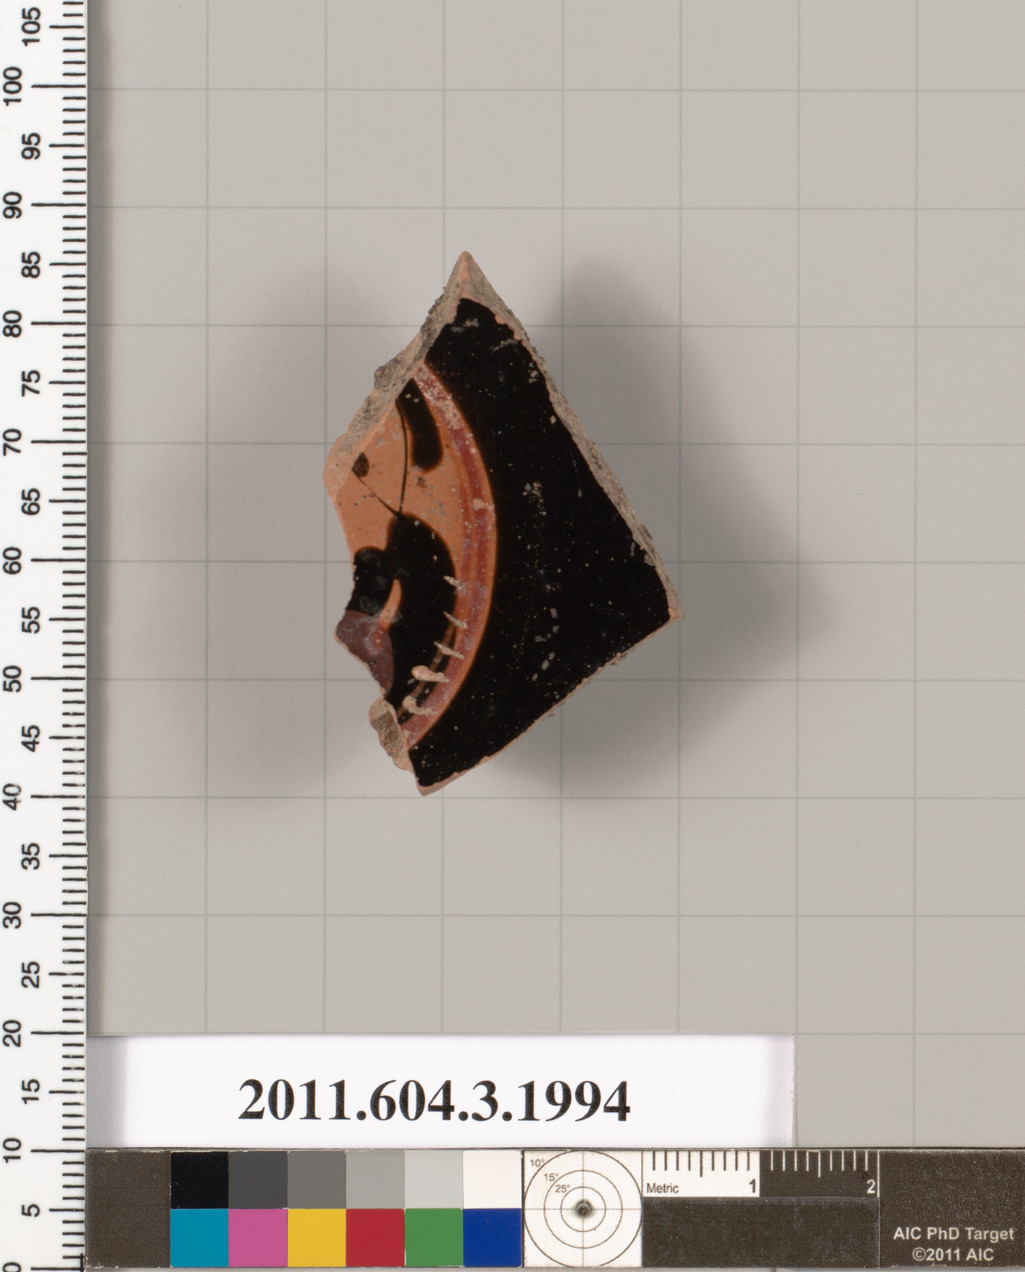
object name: kylix fragment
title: Terracotta fragment of a kylix (drinking cup)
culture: greek, attic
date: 550-526 BCE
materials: terracotta